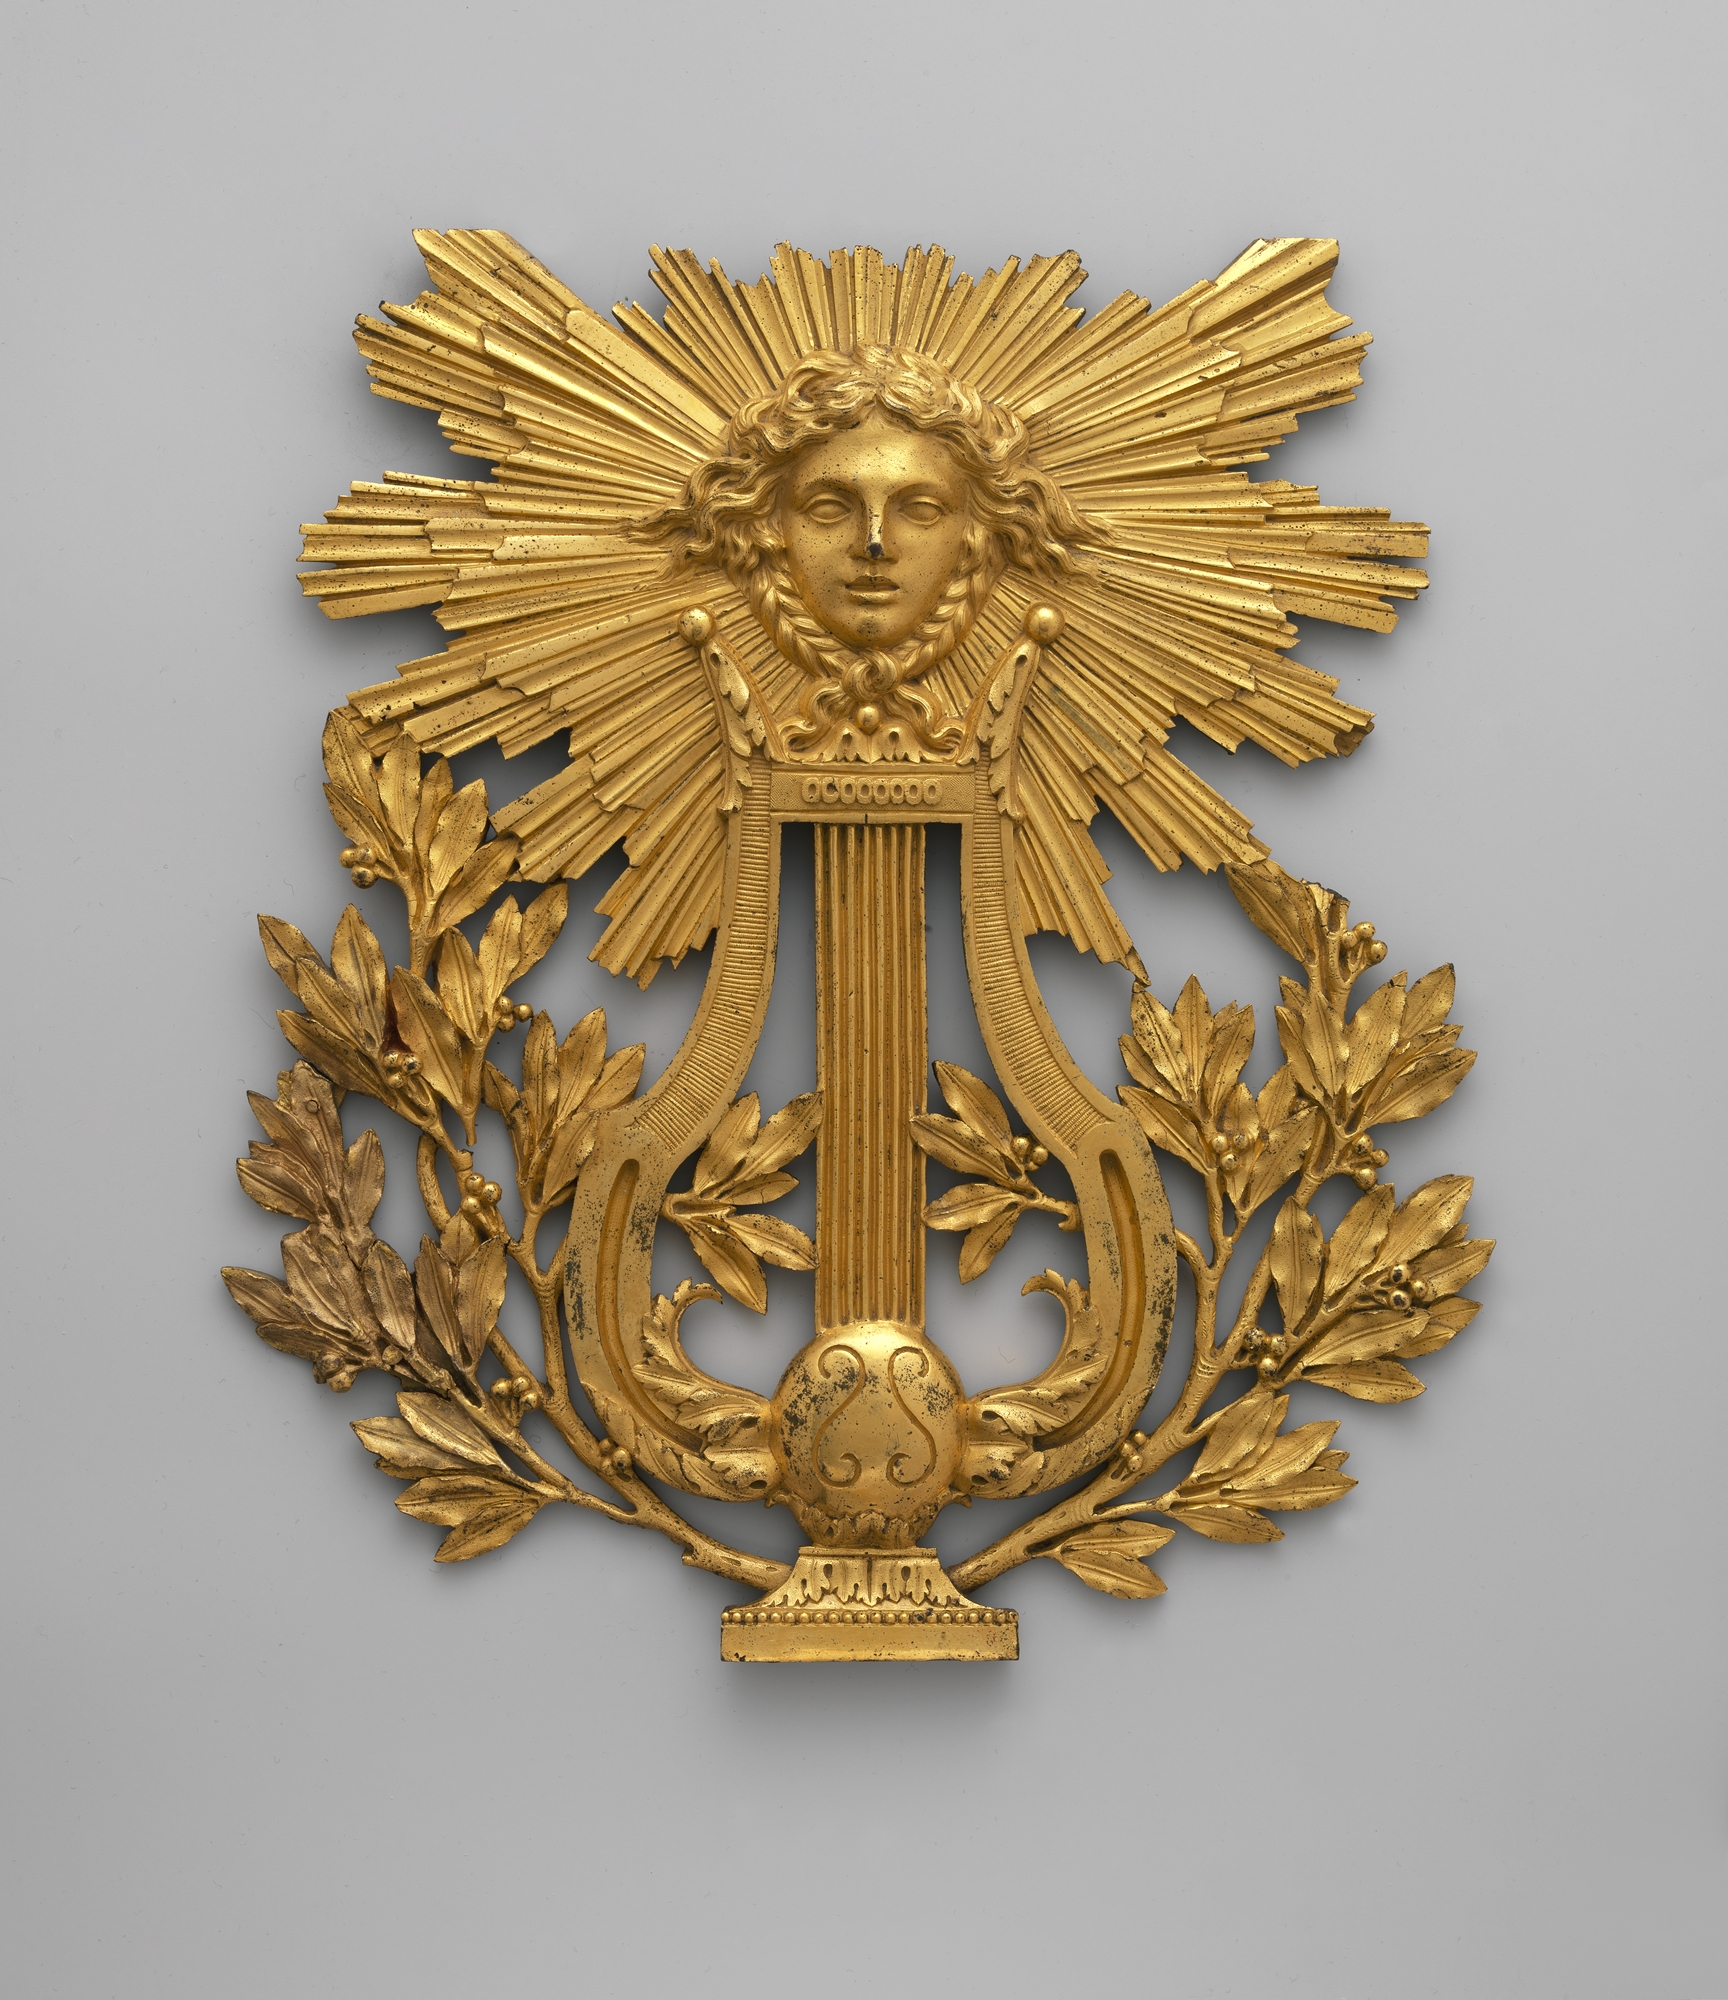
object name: panel ornament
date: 1701-1800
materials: gilt bronze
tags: faces